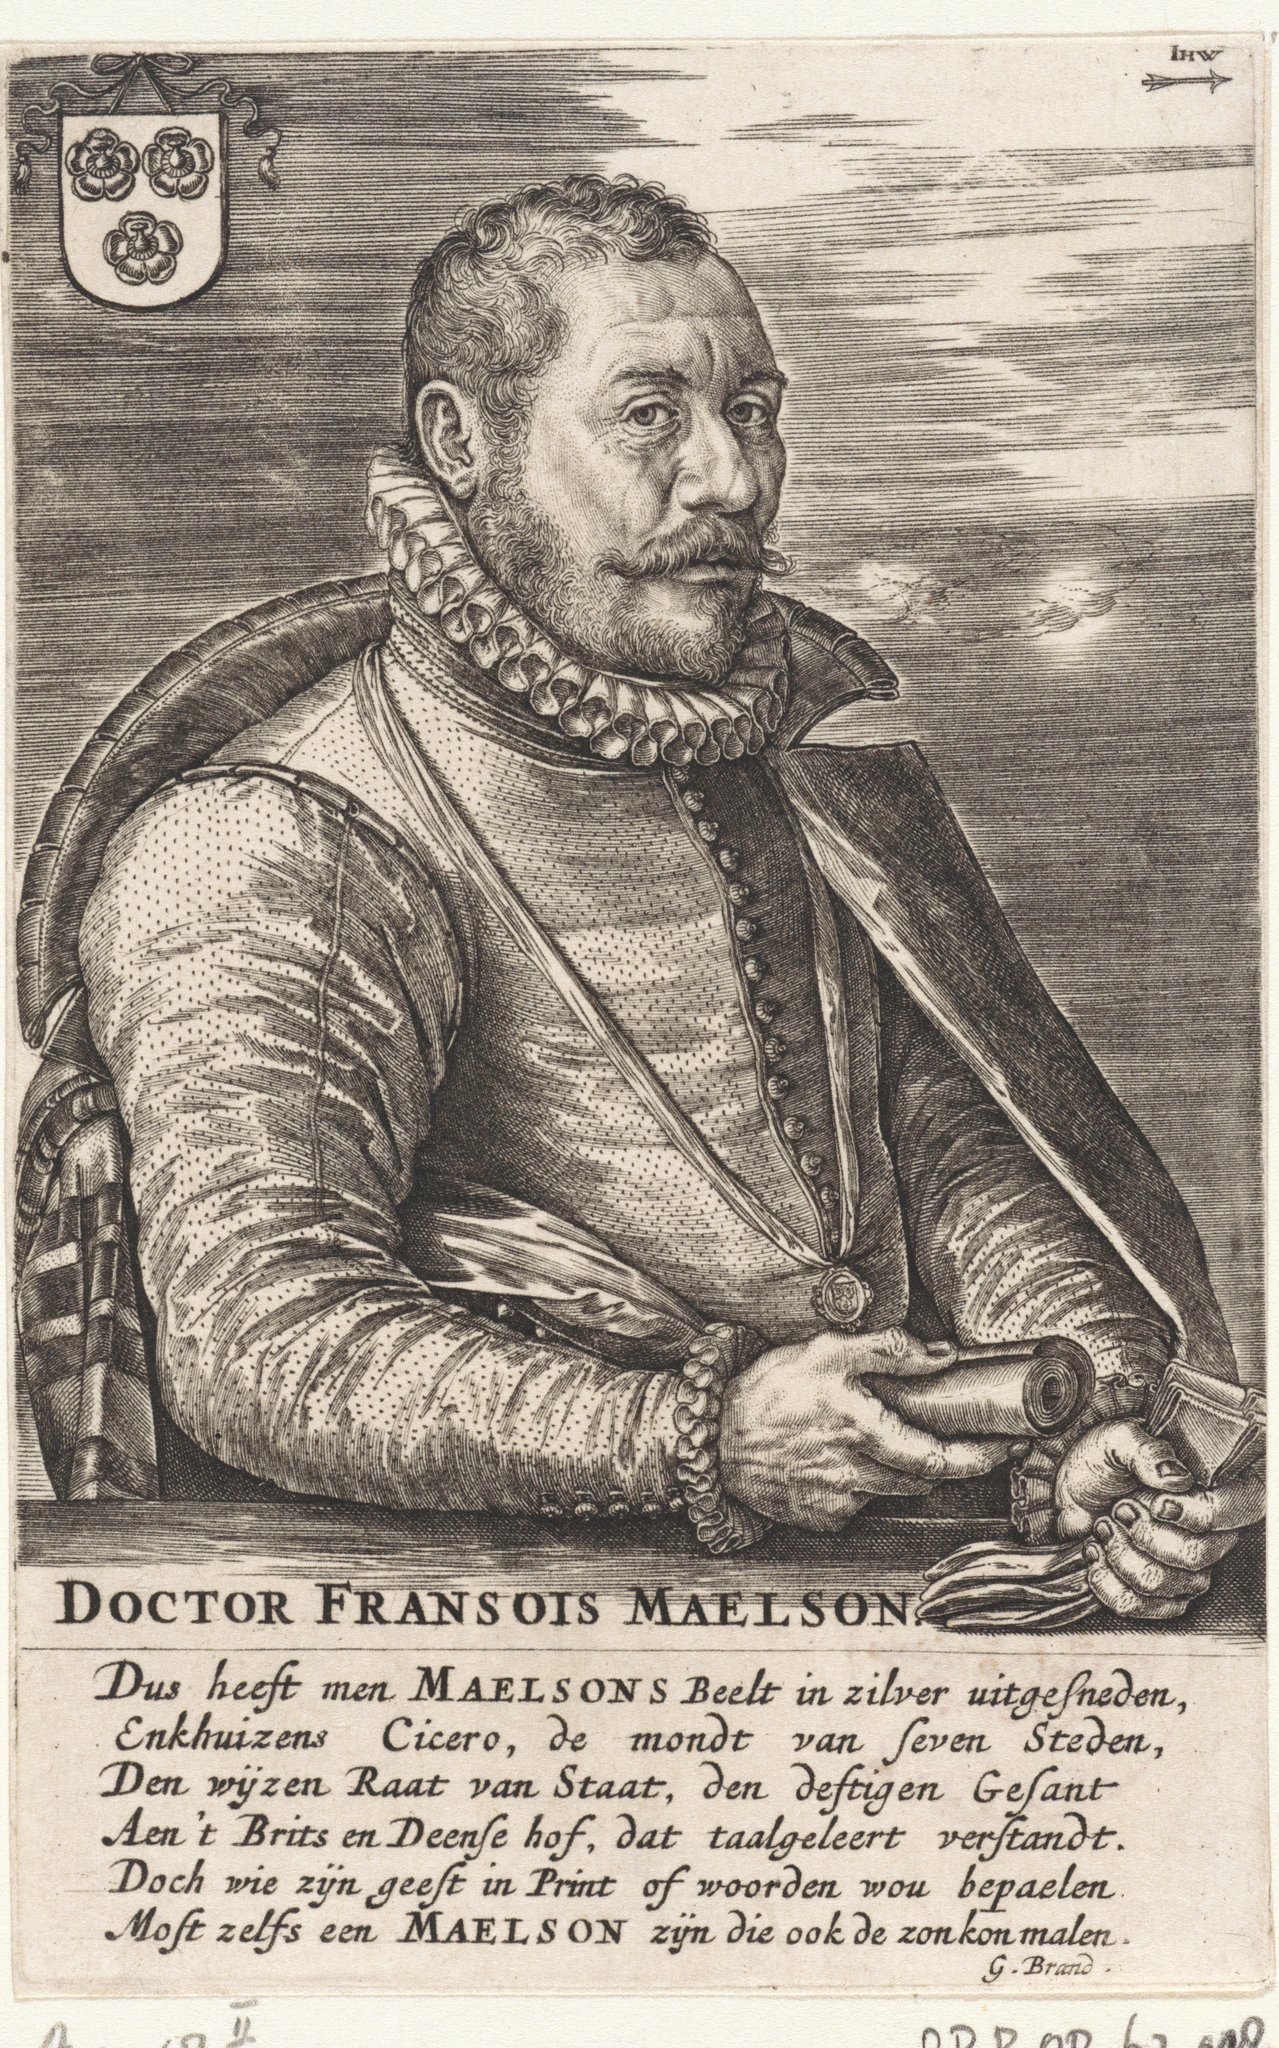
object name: print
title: Portret van François Maelson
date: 1592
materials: paper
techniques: engraving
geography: antwerp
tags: enkhuizen, armorial bearing, heraldry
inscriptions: collector's mark: Lugt 240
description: In zijn handen een opgerold vel papier en een paar handschoenen. Linksboven zijn wapenschild. In de marge een zesregelig lofdicht in het Nederlands.